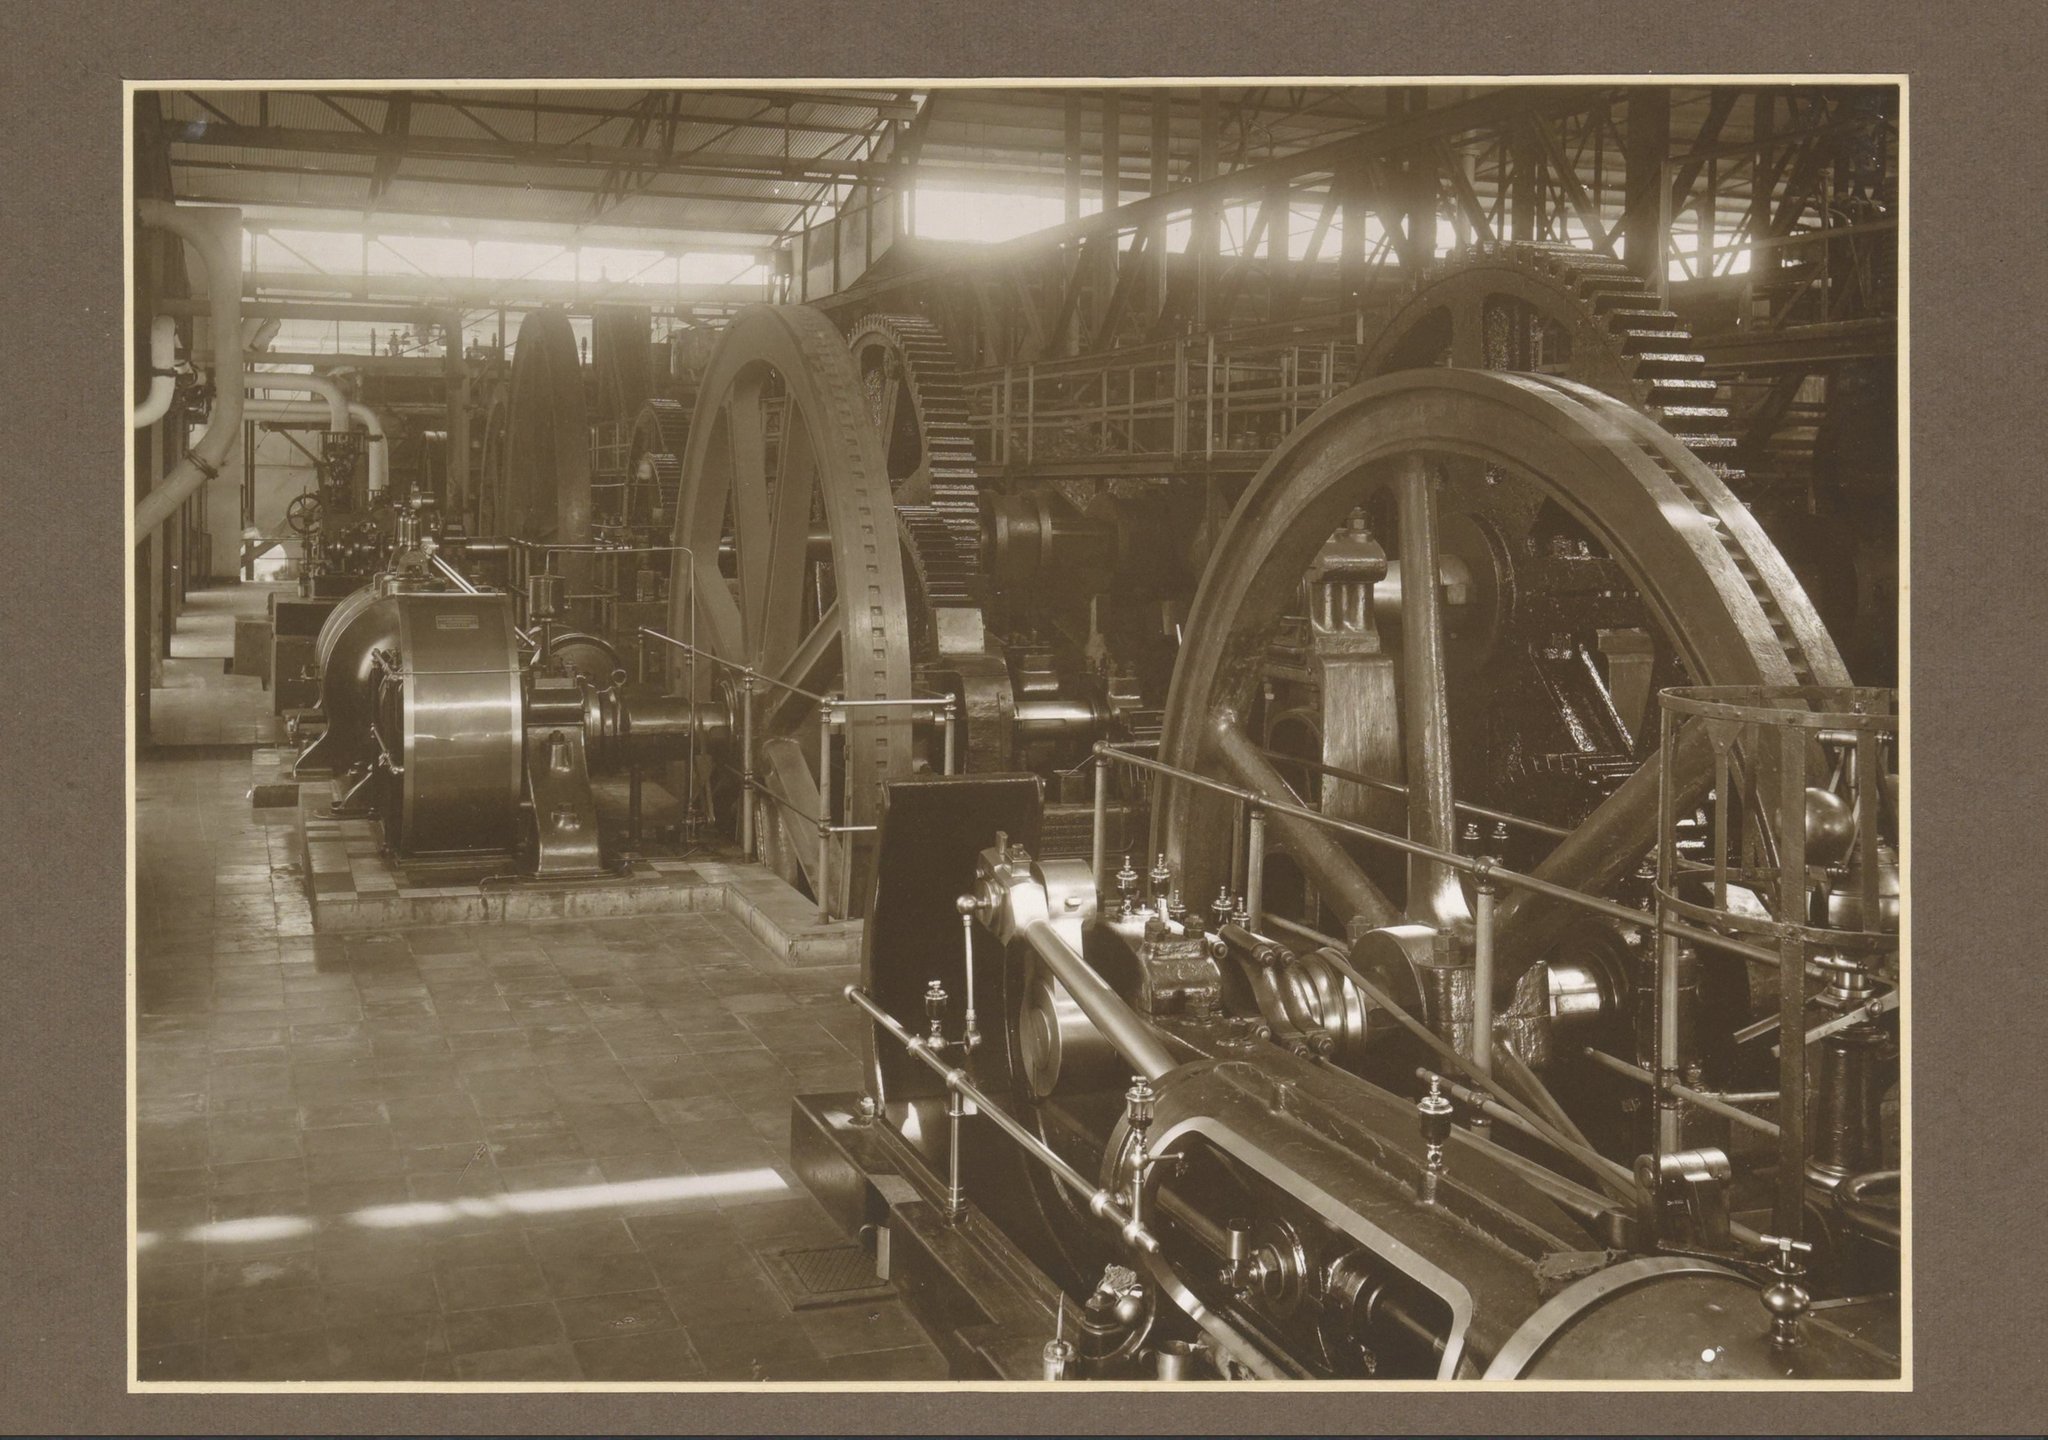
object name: photograph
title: Sf. Ngandjoek Molenstation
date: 1925-1930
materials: cardboard, paper, photographic support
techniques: gelatin silver print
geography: nganjuk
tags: plantation, factory-interior, machine shop, plants and herbs: sugarcane, sugar, dutch east indies, the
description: Onderdeel van Fotoalbum met opnames van vier suikerfabrieken op Java.